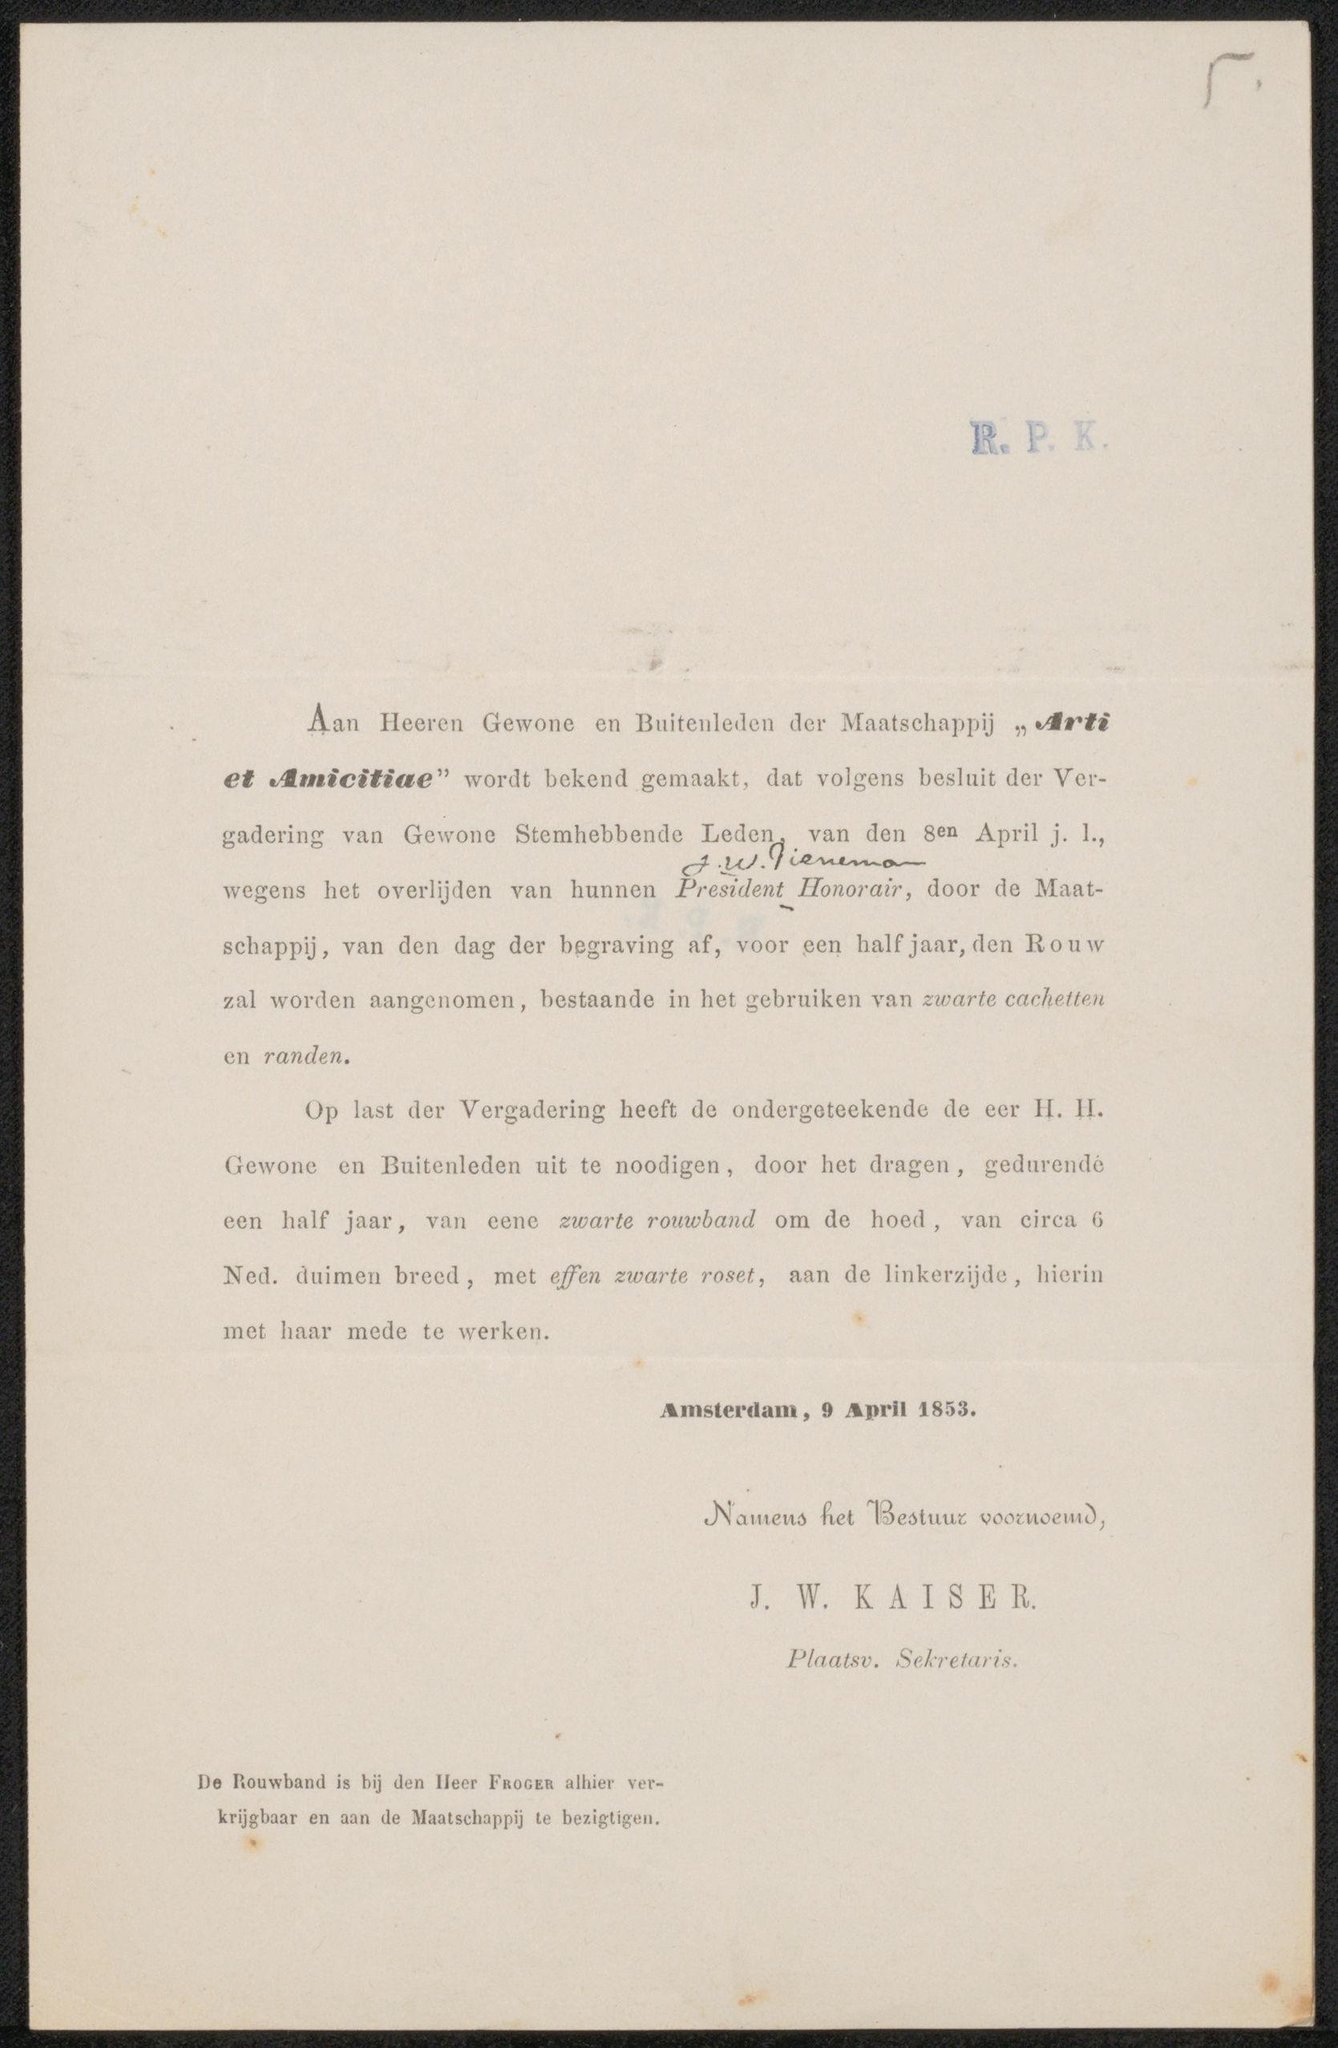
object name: letter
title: Brief aan de gewone leden en buitenleden van Arti et Amicitiae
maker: johann wilhelm kaiser (i)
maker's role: draughtsman, print maker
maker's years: 1813-1900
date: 1853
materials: ink, paper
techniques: printing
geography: amsterdam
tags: abcoude, amsterdam, painter, draughtsman, jan willem pieneman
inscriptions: collector's mark: Lugt 2233